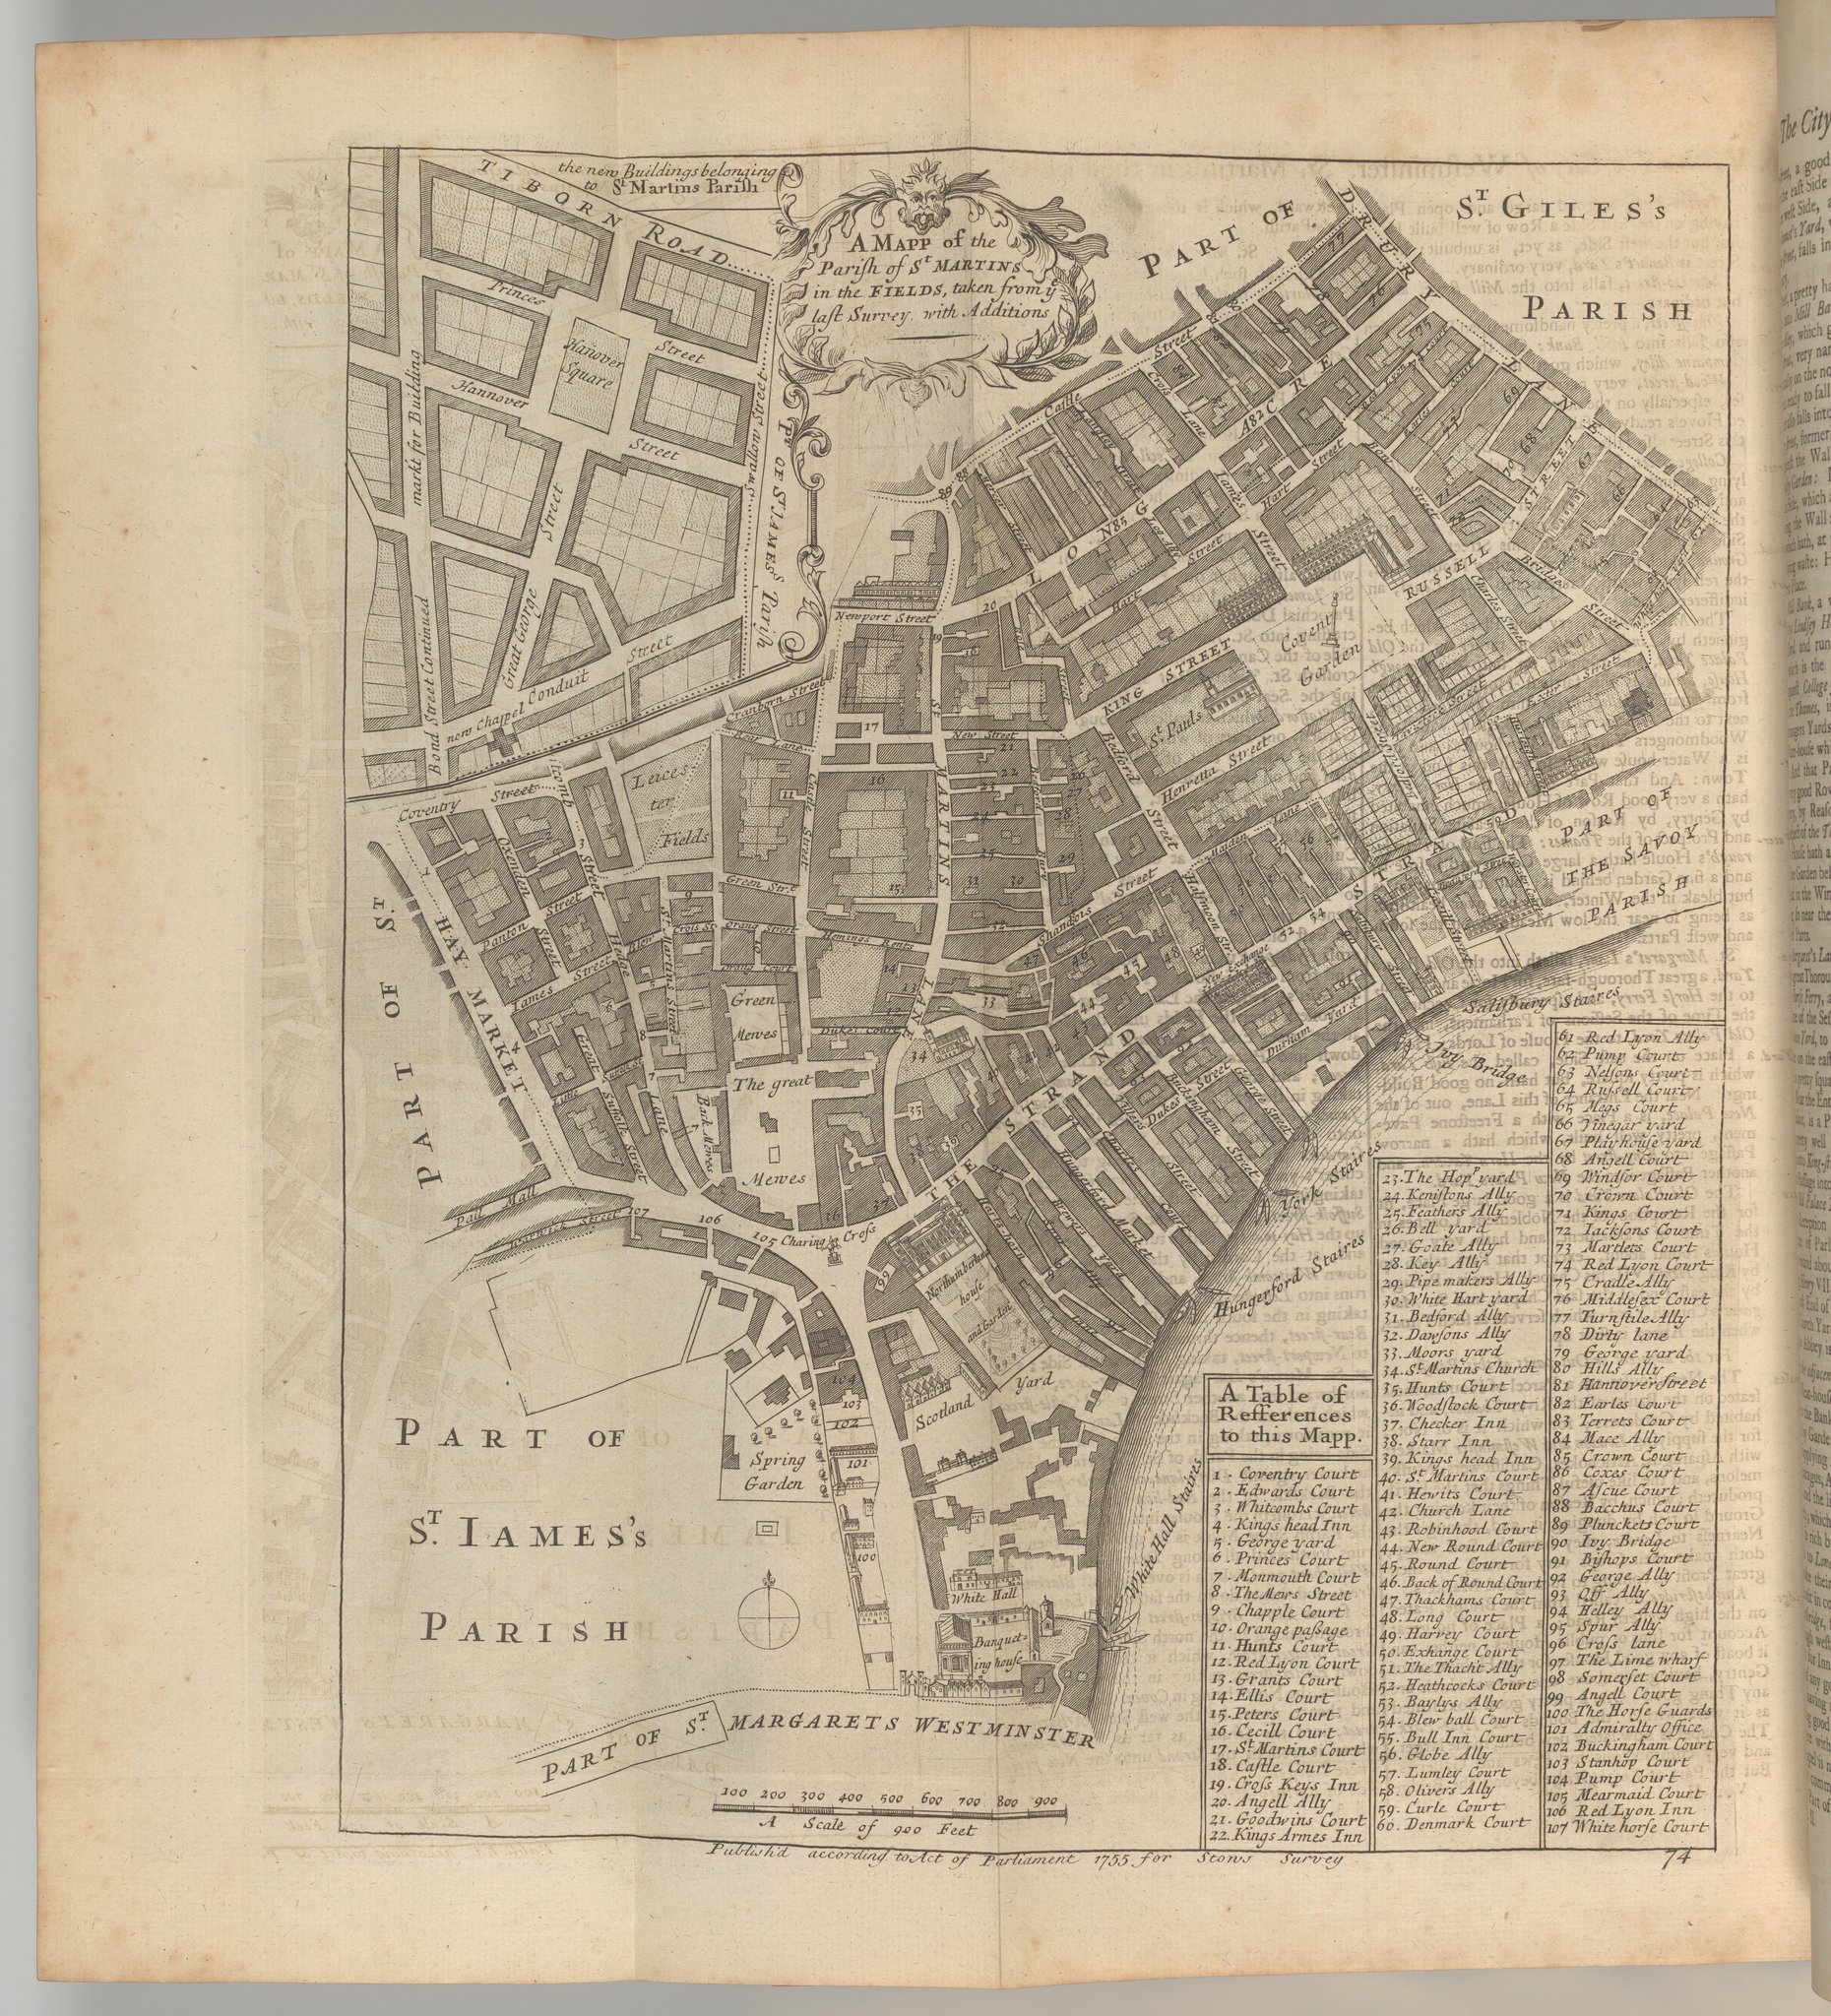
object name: book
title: A survey of the cities of London and Westminster and the Borough of Southwark written at first in the year 1698 (i.e. 1598)..Corrected, improved, and very much enlarged in the year 1720 by John Strype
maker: john stow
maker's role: author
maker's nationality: british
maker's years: 1525-1605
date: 1754-1755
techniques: engraving, etching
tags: cities,maps,london